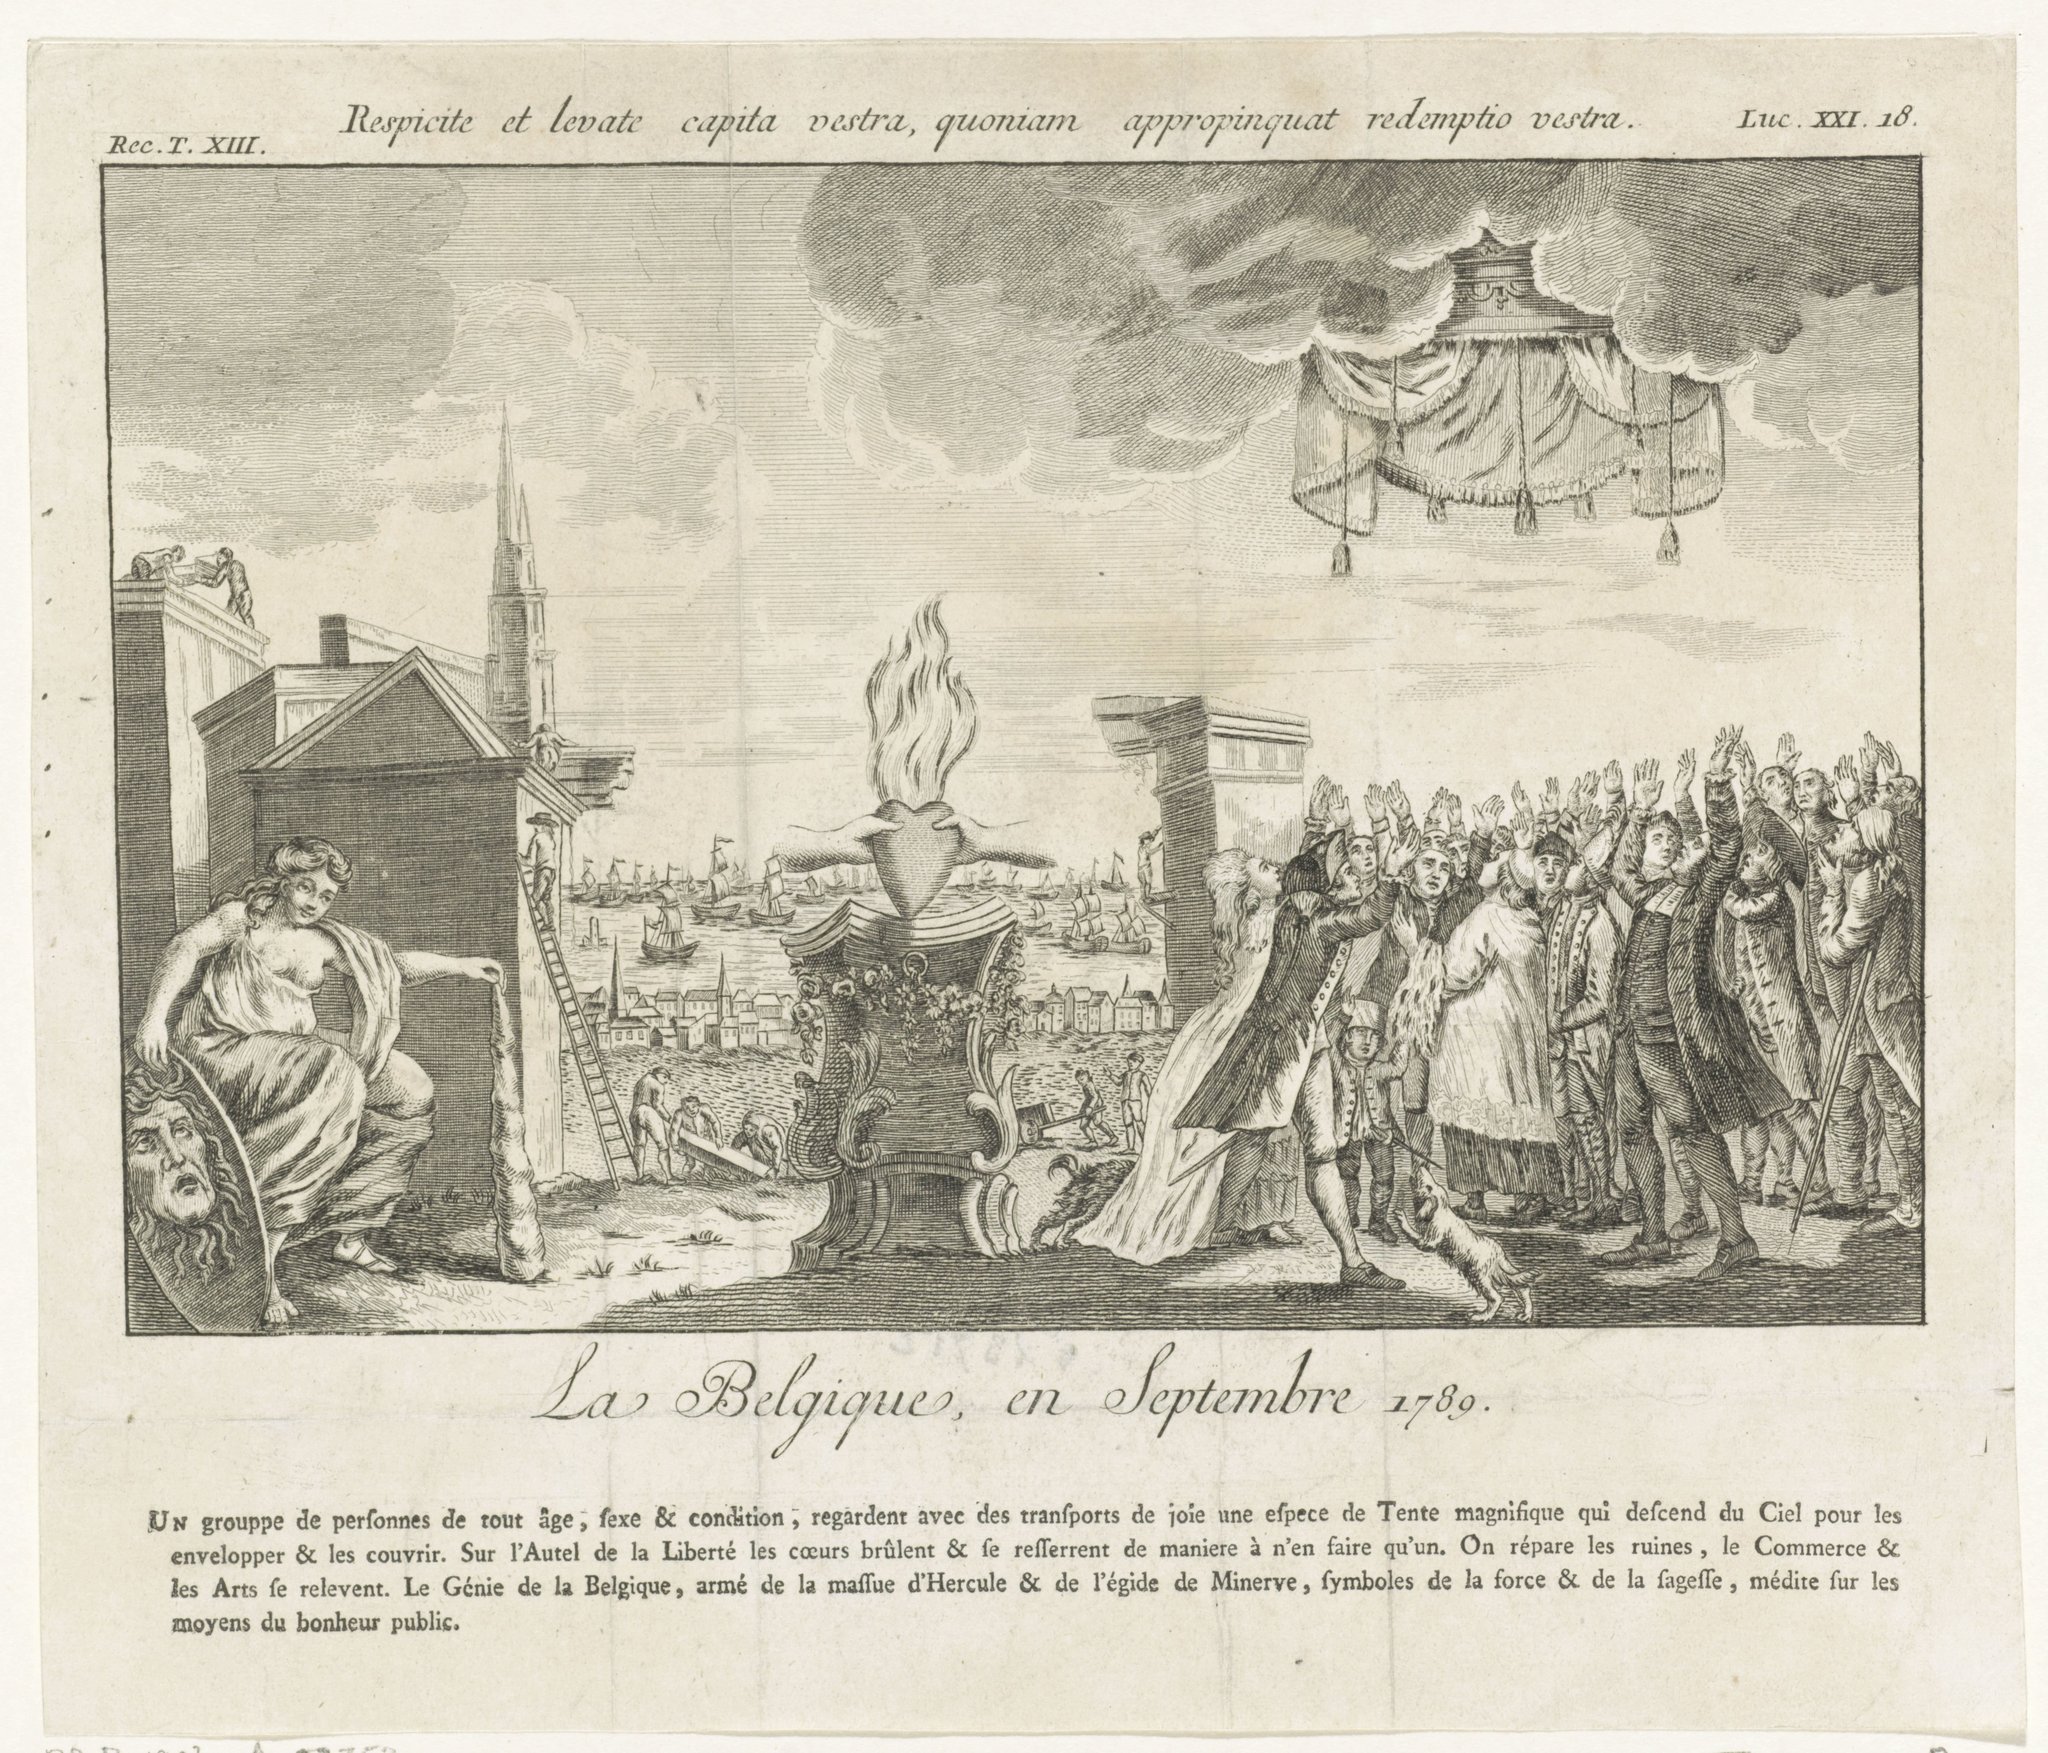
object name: print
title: La Belgique, en Septembre 1789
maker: Anonymous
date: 1789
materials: paper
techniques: engraving, letterpress printing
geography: southern netherlands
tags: personifications of countries, nations, states, districts, etc., belgium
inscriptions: collector's mark: Lugt 2228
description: Allegorie op de Brabantse Omwenteling tegen het Oostenrijkse gezag in 1789. Een menigte steek de handen in de lucht bij het in de lucht opstijgen van een troonhemel of tent. In het midden het symbool van twee handen met een vlammend hart op een altaar. Links de Belgische Maagd. Op het blad onder de plaat een Frans onderschrift van vier regels.